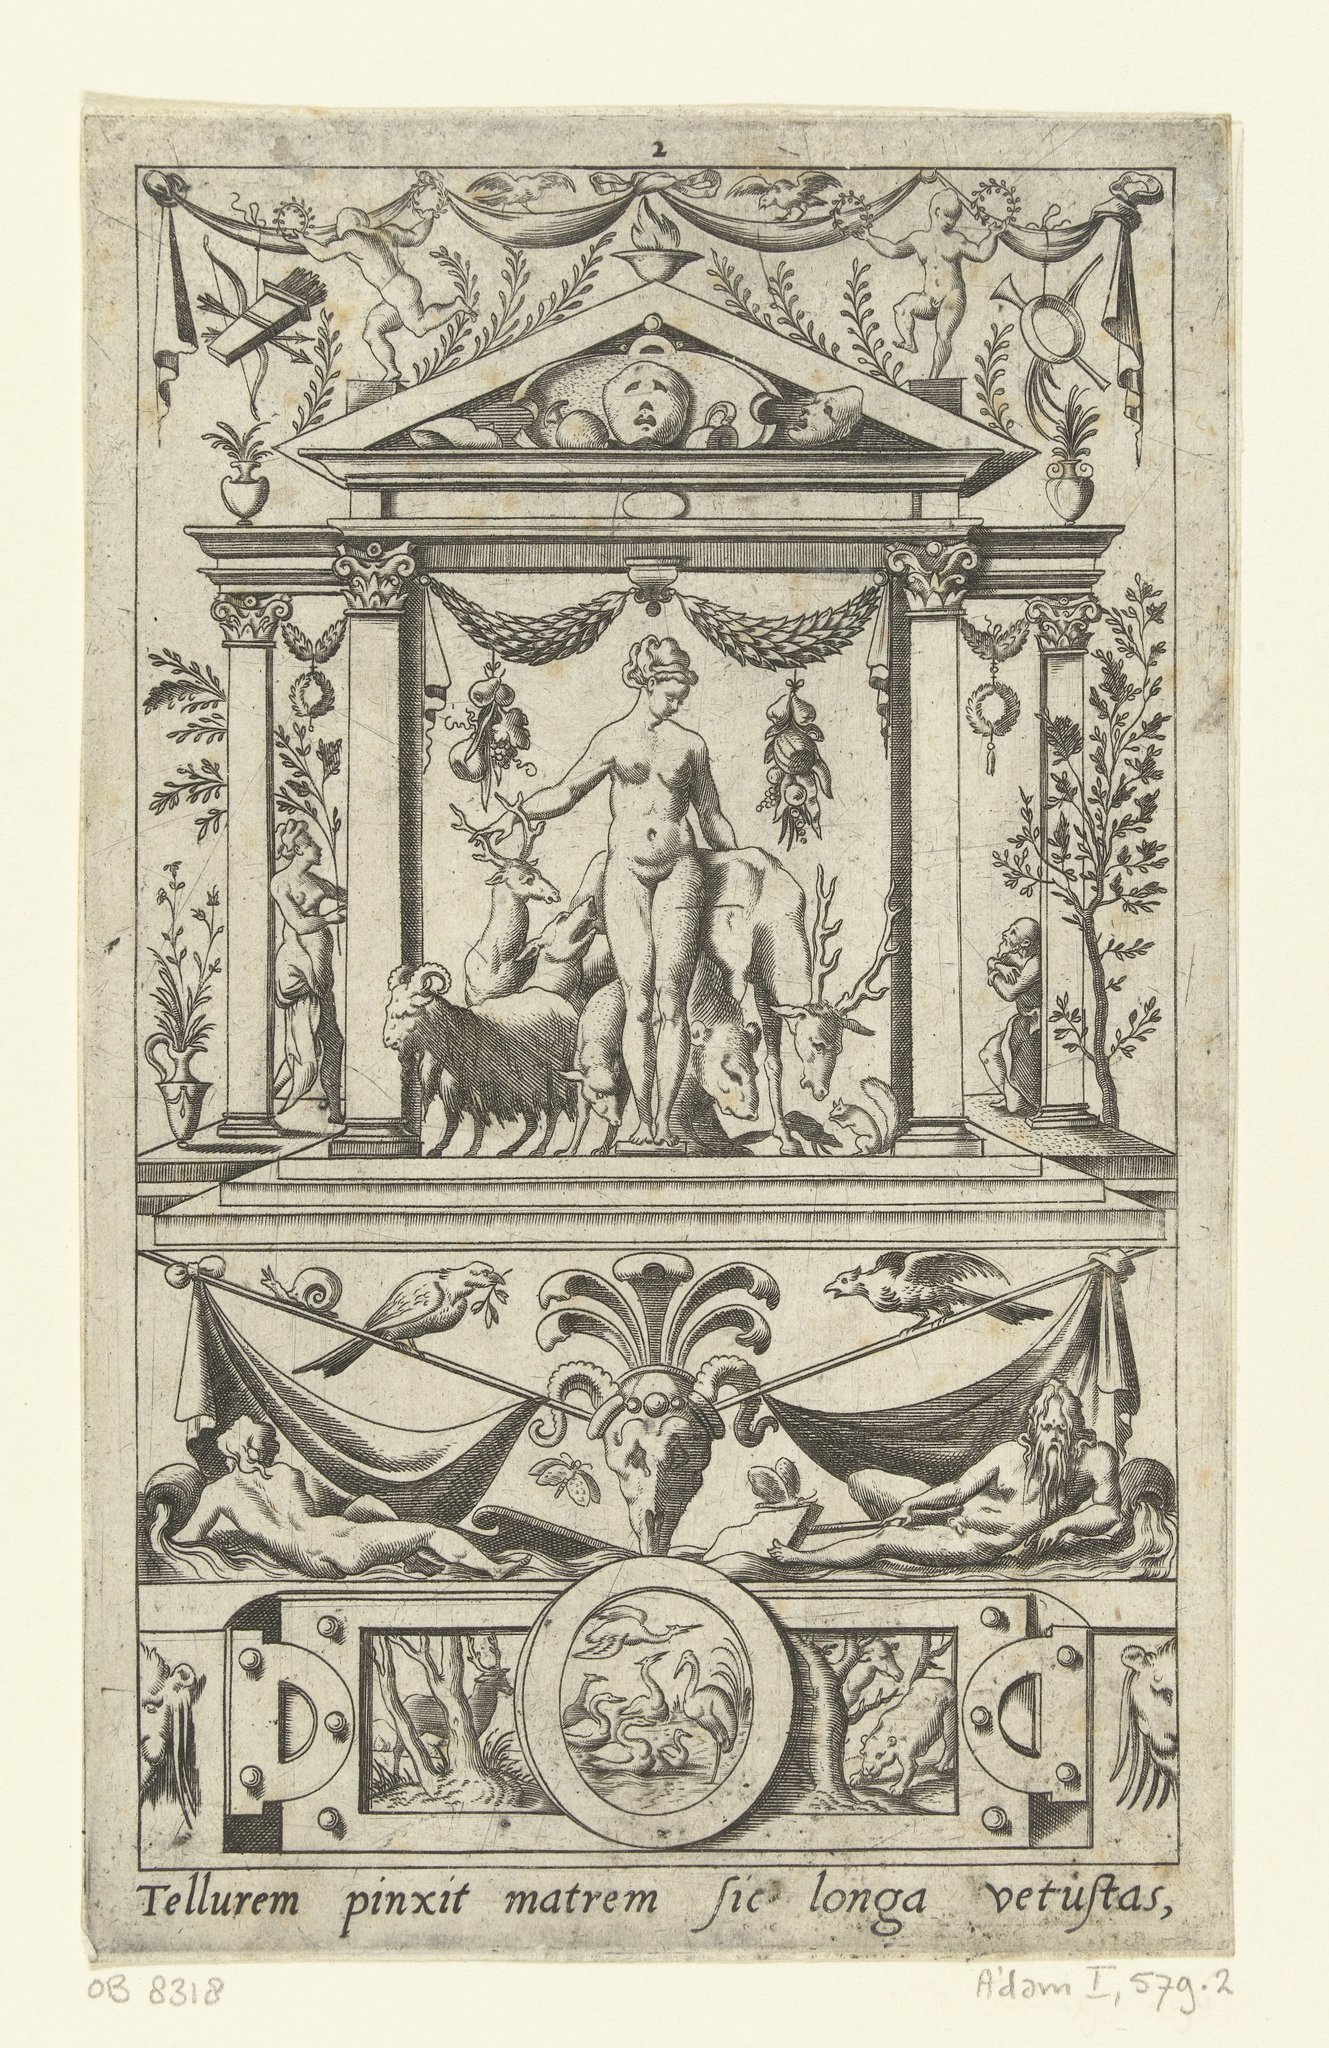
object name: ornament print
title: Saturnus zet zijn tanden in een van zijn kinderen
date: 1551-1580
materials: paper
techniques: engraving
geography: france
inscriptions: collector's mark: Lugt 240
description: Onderaan staat een Latijnse tekst. Uit serie van 16 deels genummerde bladen met vlakdecoraties van goden en godinnen in een omlijsting van grotesken met fantastische wezens, dieren, guirlandes en mascarons.